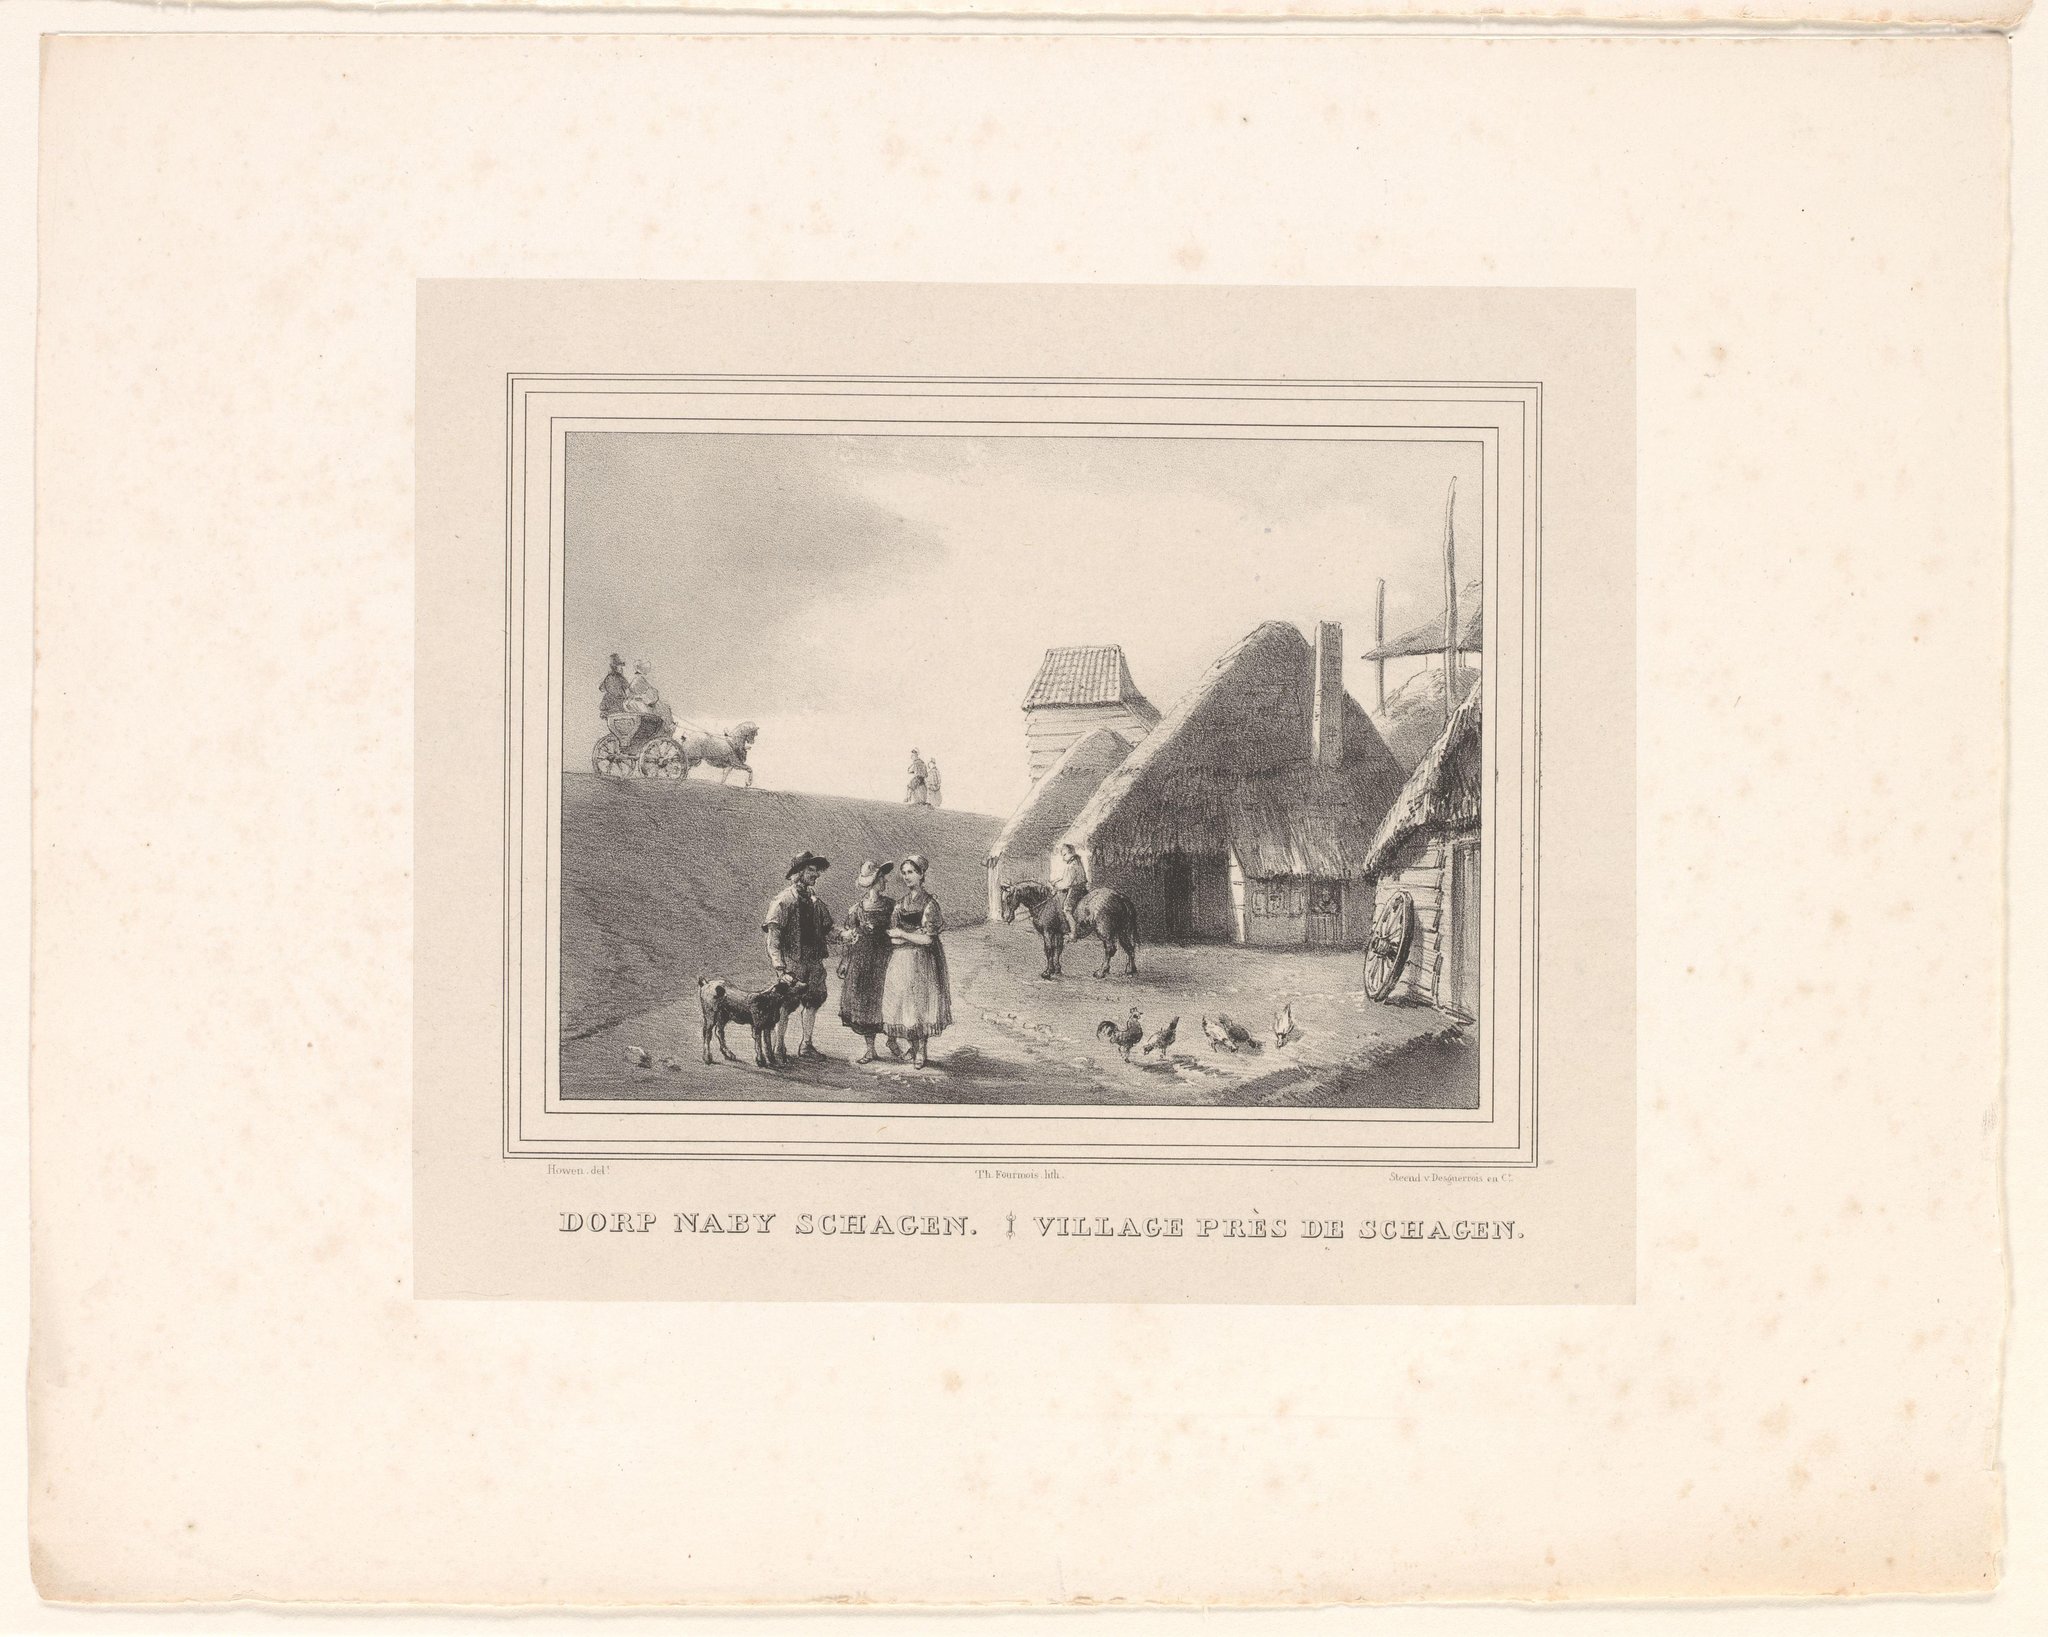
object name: print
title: Zes verschillende voorwerpen uit Noordholland / Six sujets divers de la Nordhollande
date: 1827-1871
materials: paper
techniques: lithograph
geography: amsterdam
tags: riding a horse, ass, or mule; rider, horseman, fowl (cock, hen, chicken, etc.), village (+ city(-scape) with figures, staffage), schagen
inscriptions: collector's mark: Lugt 2228